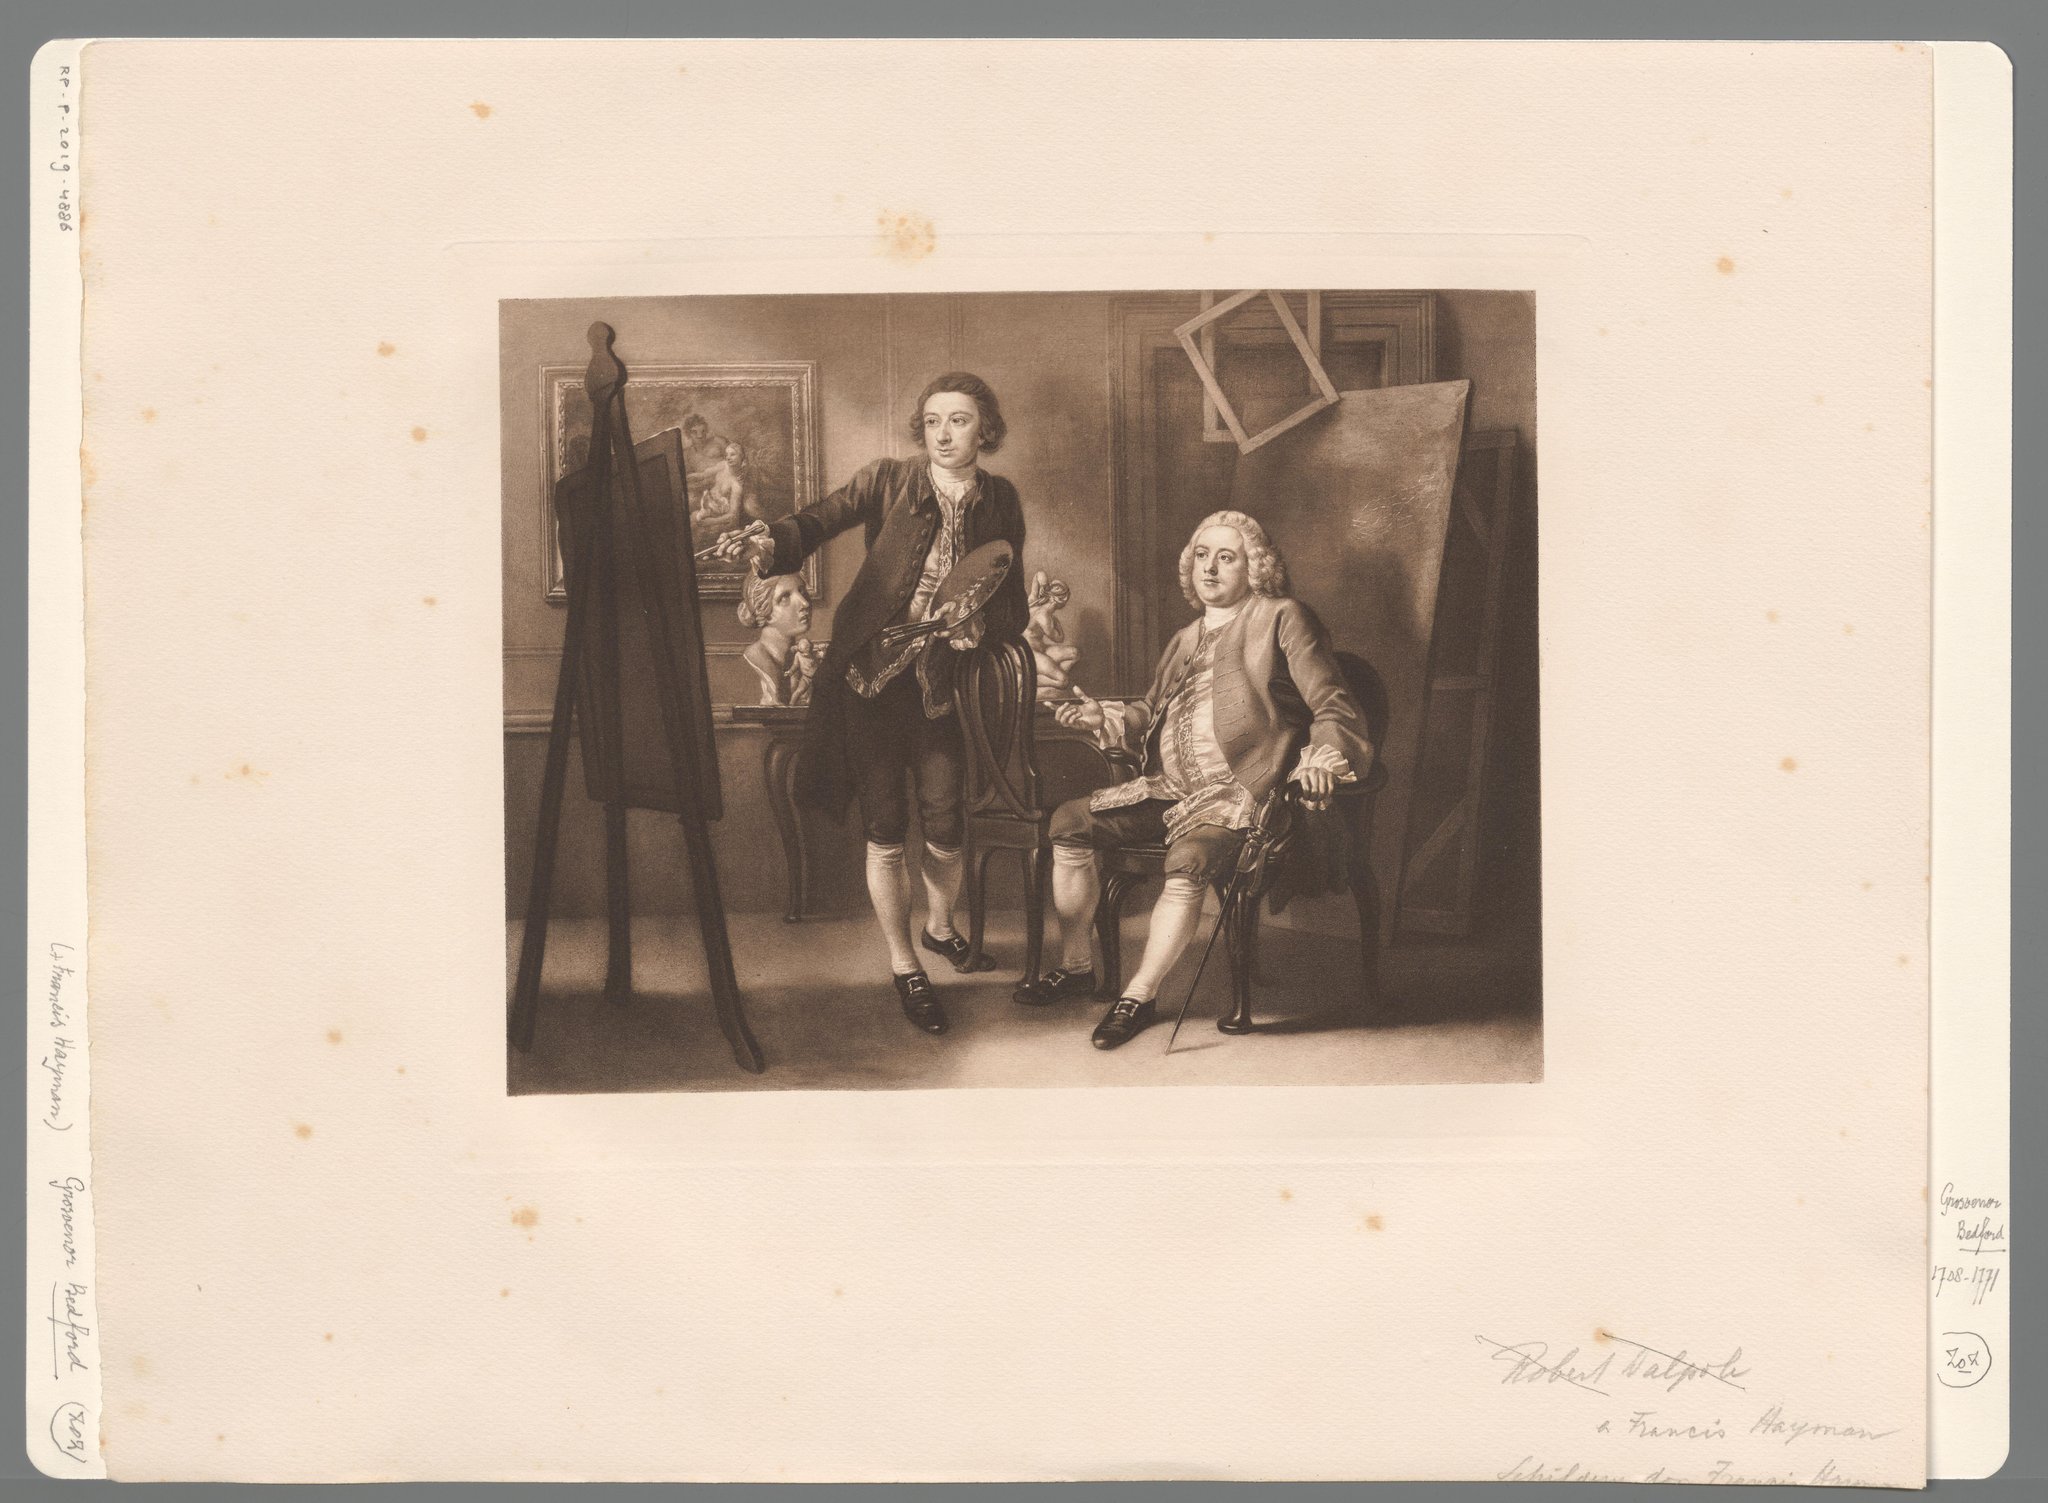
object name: photomechanical print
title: Dubbelportret van Francis Hayman en Grosvenor Bedford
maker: Anonymous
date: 1870-1915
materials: paper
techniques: photoaquatint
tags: london, painter, print maker, draughtsman, francis hayman, historical persons, portrait, self-portrait of painter, piece of sculpture, reproduction of a piece of sculpture, picture, painting